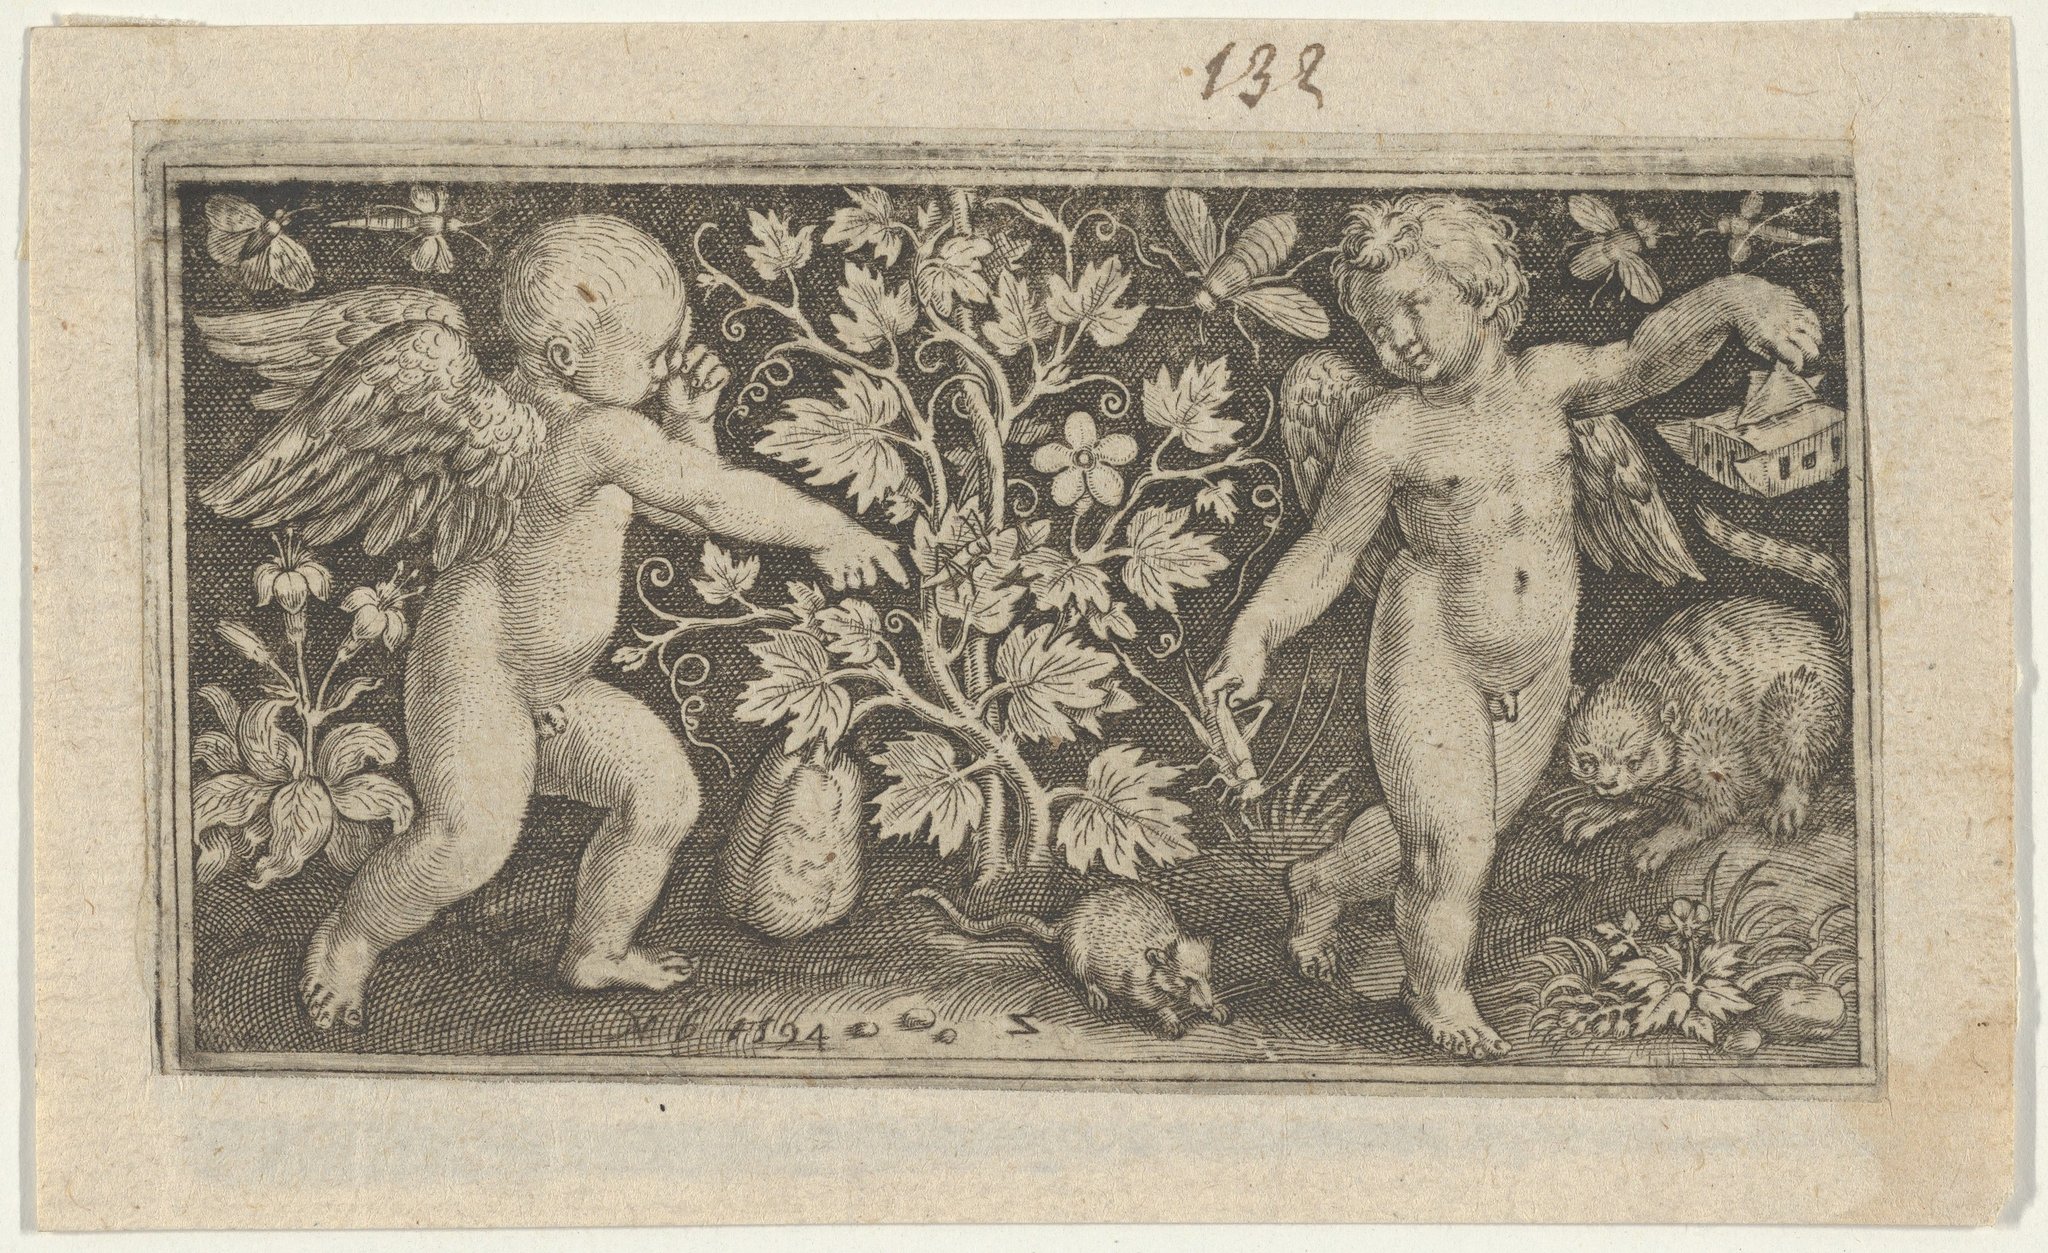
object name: print ornament architecture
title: Two Genii with a Cat and a Rat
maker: nicolaes de bruyn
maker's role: artist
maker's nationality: netherlandish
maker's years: 1571-1656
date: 1594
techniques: engraving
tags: putti,cats,rats